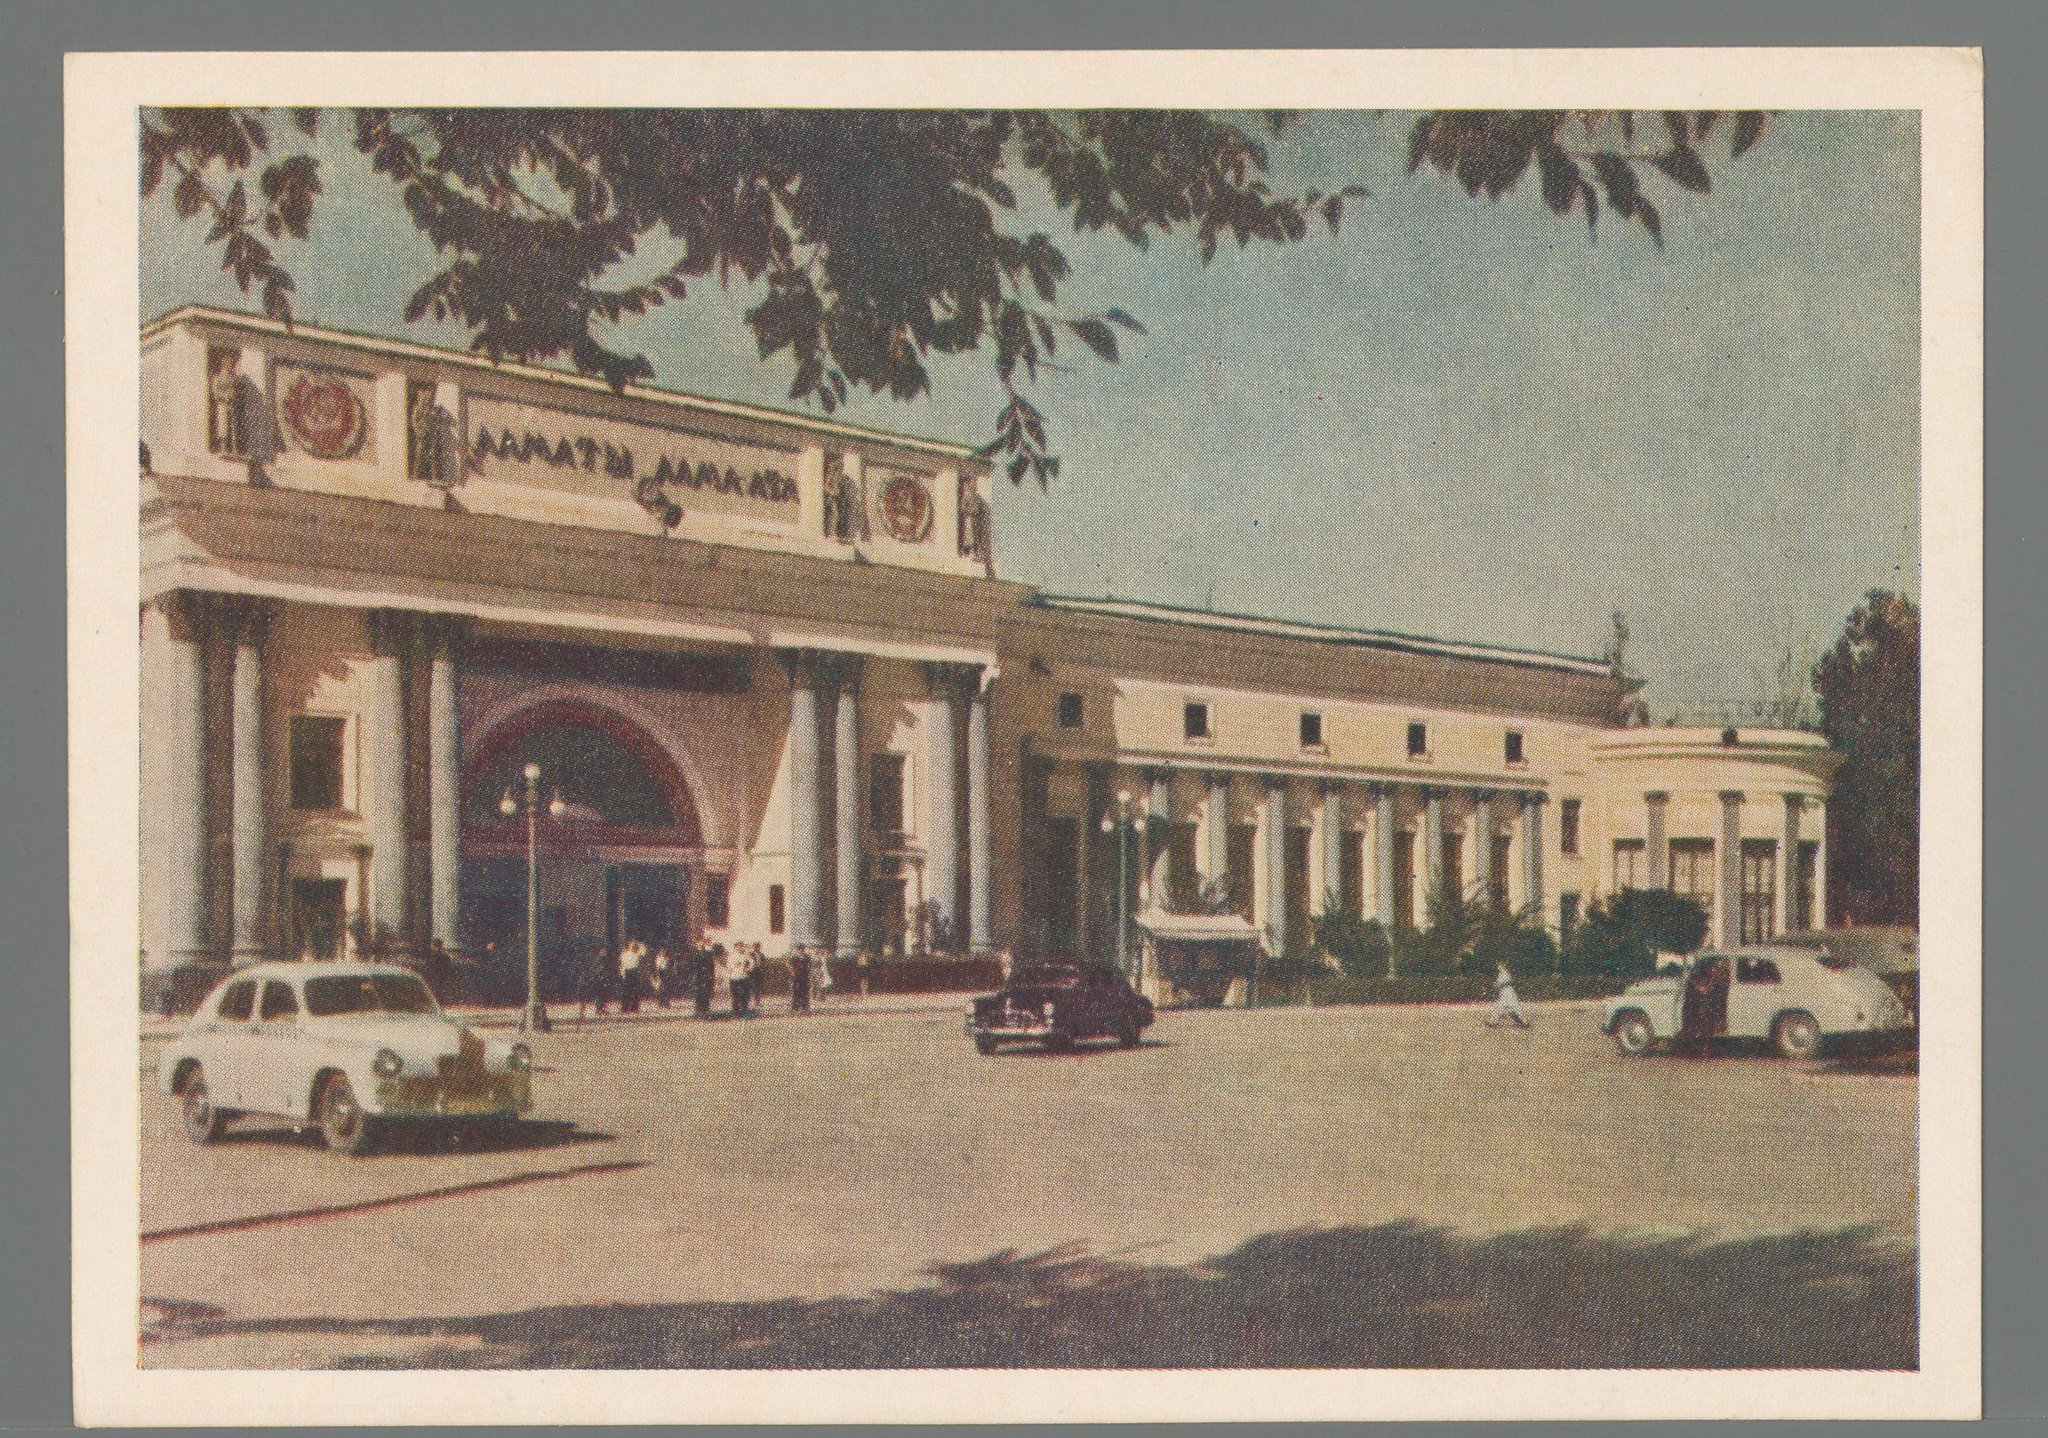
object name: photomechanical print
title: Kazakh S.S.R. Alma-Ata. Railway Station / R.S.S. de Kazakhie. Alma-Ata. Gare / Kasachische SSR. Alma-Ata. Bahnhof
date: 1956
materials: cardboard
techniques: color autotype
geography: moscow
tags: station; shelter (railway, tramway)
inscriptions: date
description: De titel op object staat ook in het Russisch.